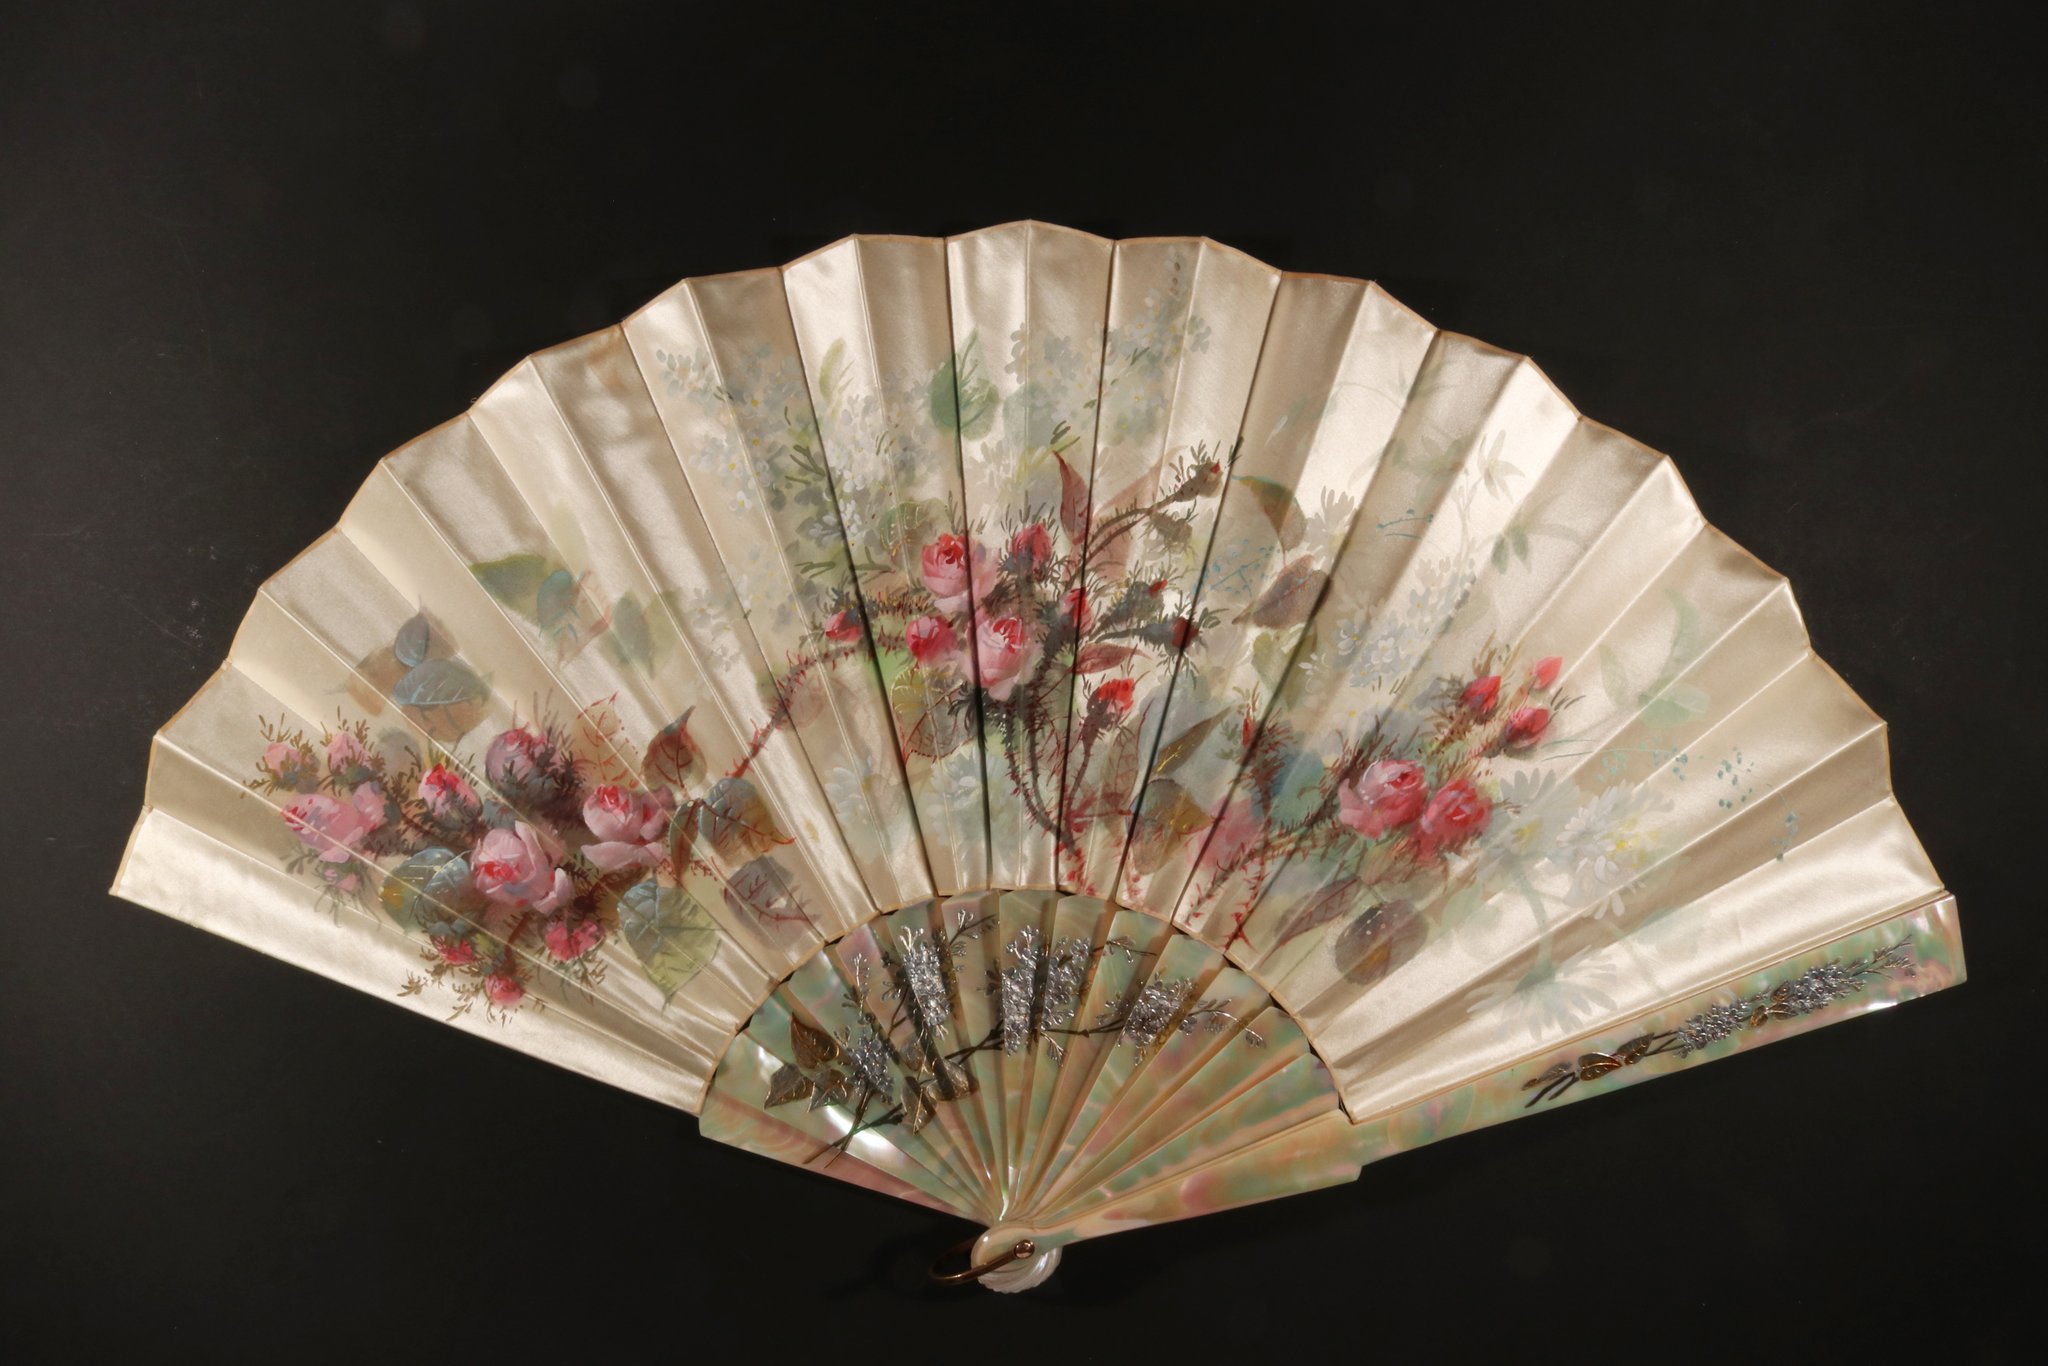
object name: fan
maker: tiffany & co.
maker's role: retailer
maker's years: 1837-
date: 1867-1900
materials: enamel, metal, mother of pearl, silk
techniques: painting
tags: roses